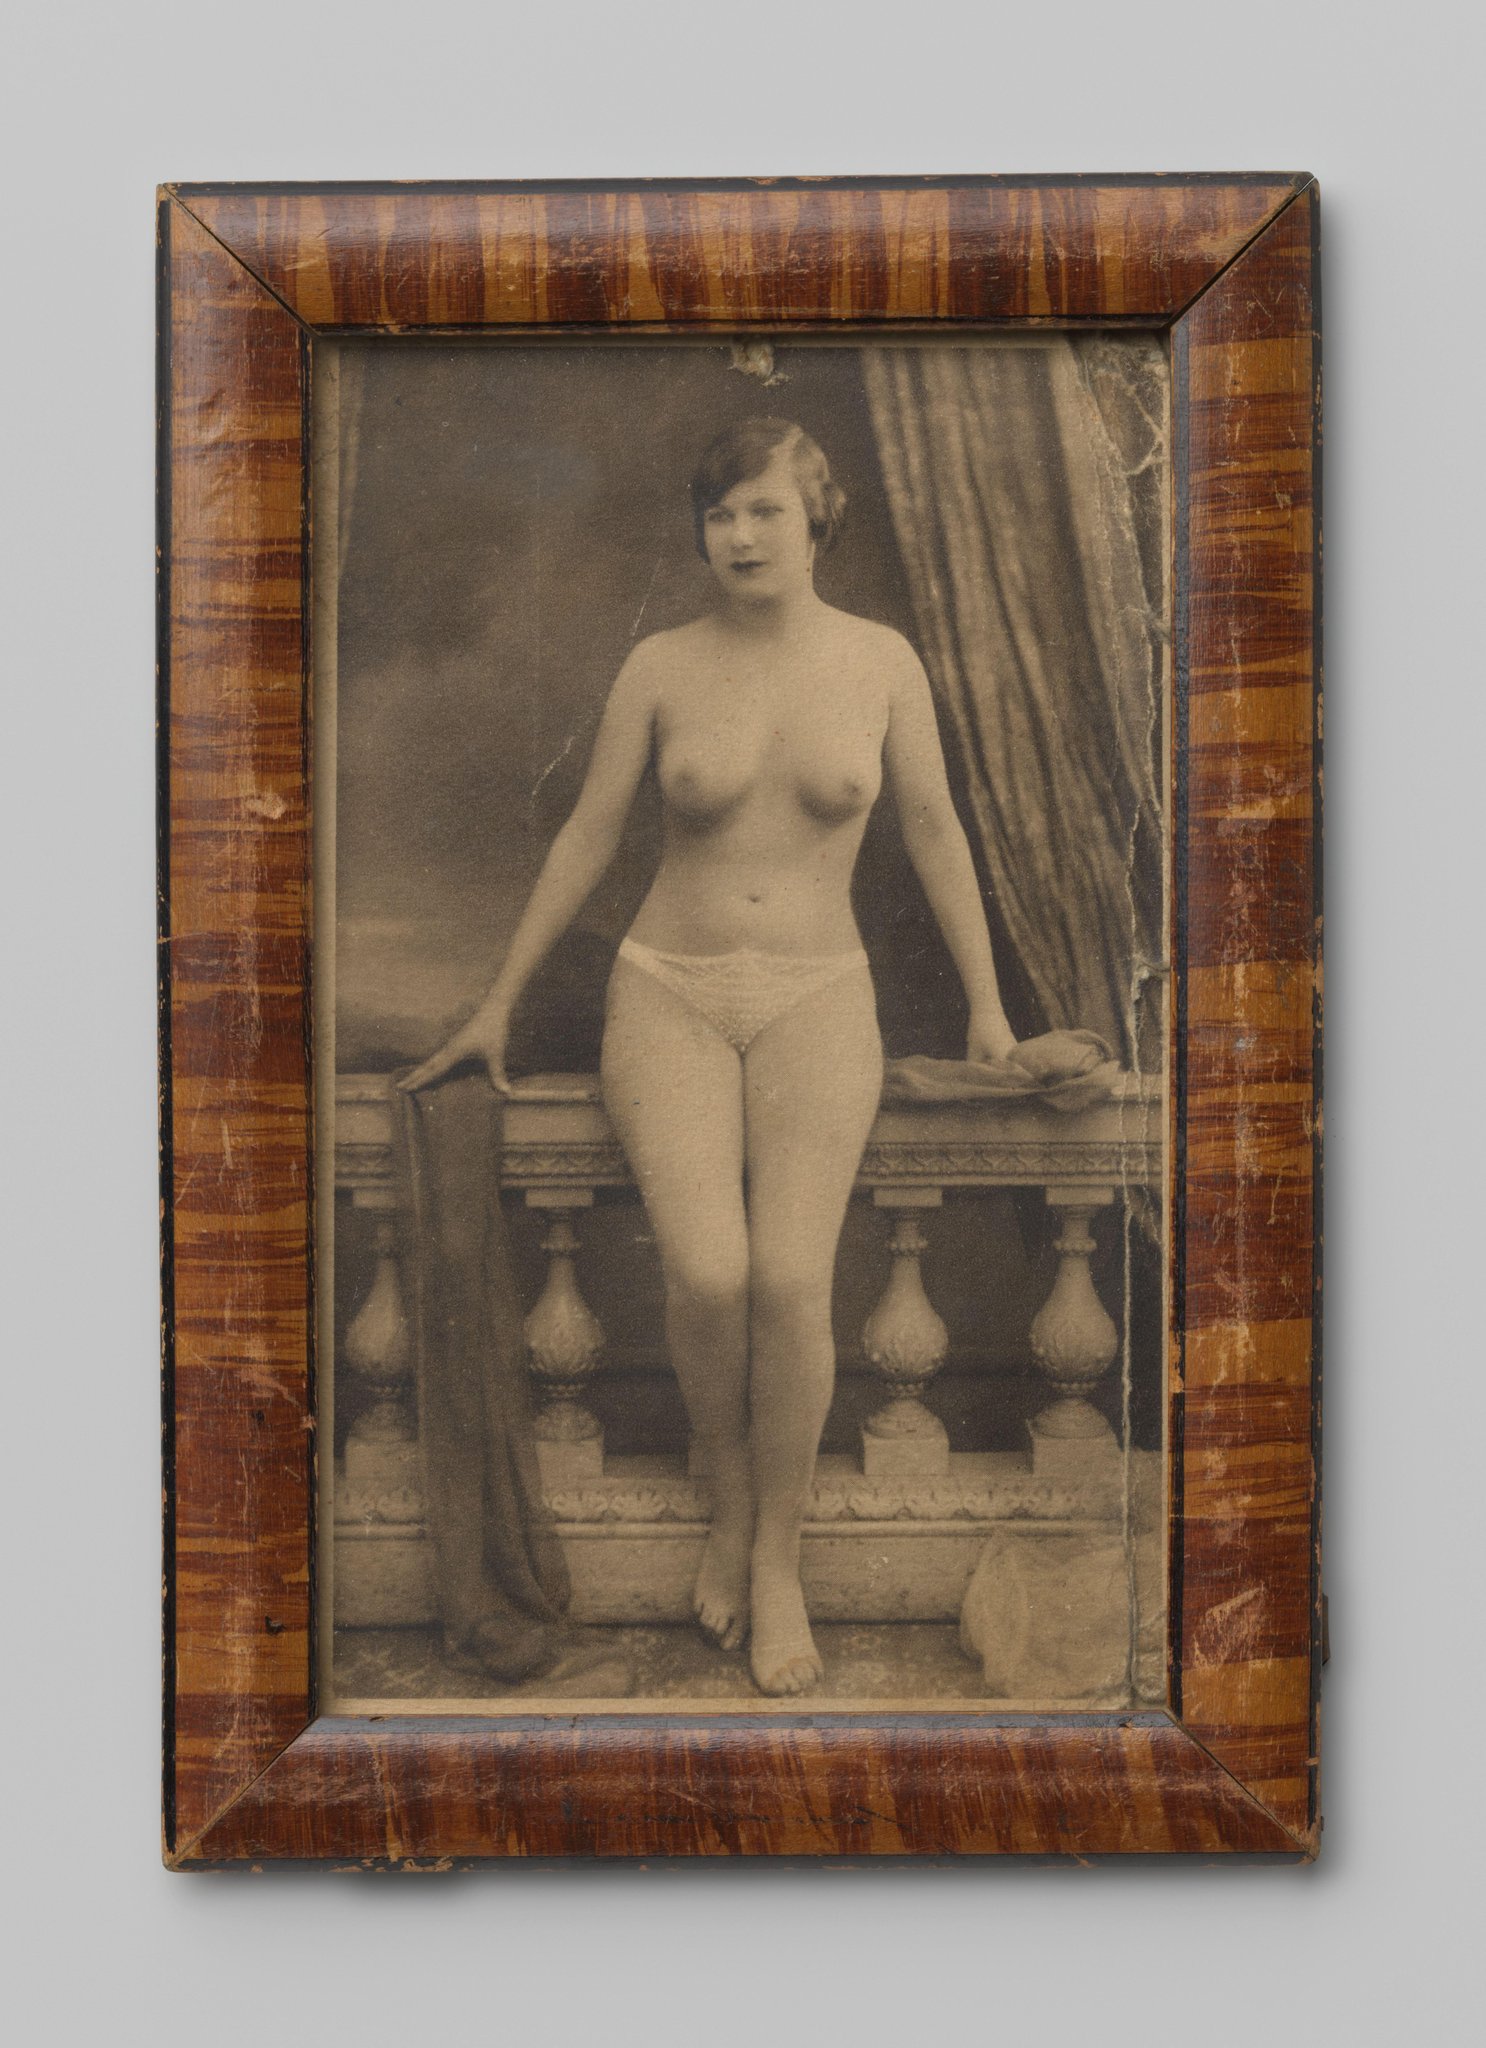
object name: frame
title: Portret van een vrouw in kanten onderbroek, mogelijk actrice Gina Manès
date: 1870-1910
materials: cardboard, glass, metal, paper, wood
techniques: rotogravure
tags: adult woman, woman (showing herself) undressed, quasi-nude, portrait of actor, actress